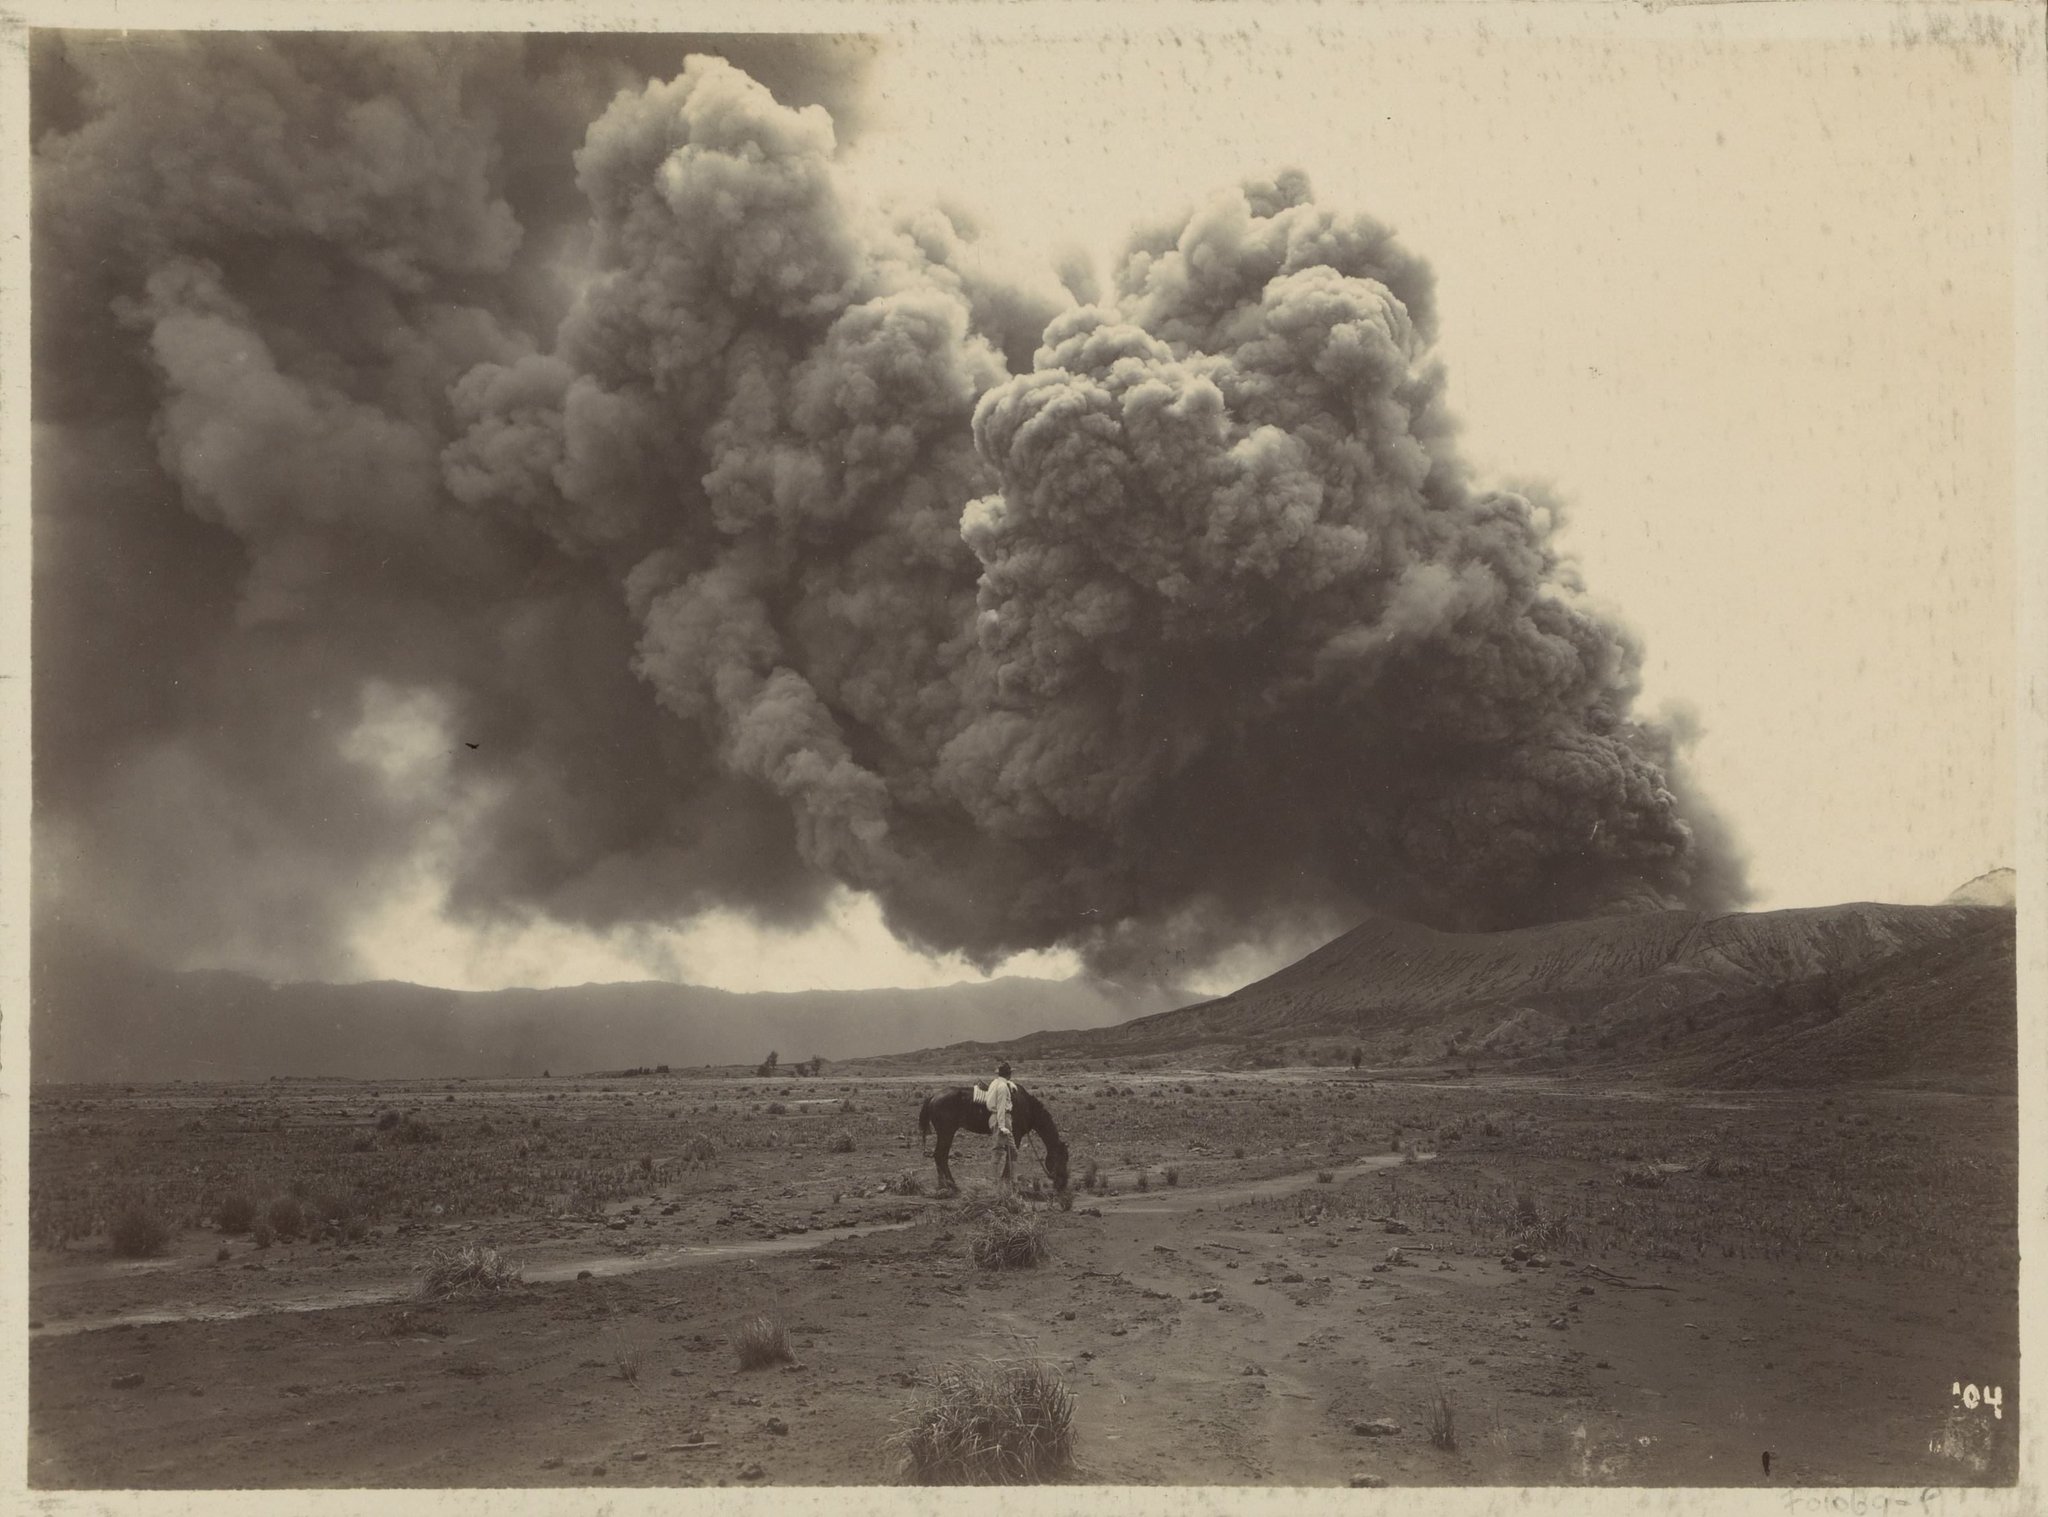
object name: photograph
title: Man met een paard voor een rokende vulkaan in Nederlands-Indië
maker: onnes kurkdjian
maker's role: fotograaf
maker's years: 1851-1903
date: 1912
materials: paper, photographic support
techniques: gelatin silver print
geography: dutch east indies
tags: riding a horse, ass, or mule; rider, horseman, volcano, dutch east indies, the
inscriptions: number: ‘104’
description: Onderdeel van Reisalbum met veertig foto's van Nederlands-Indië.